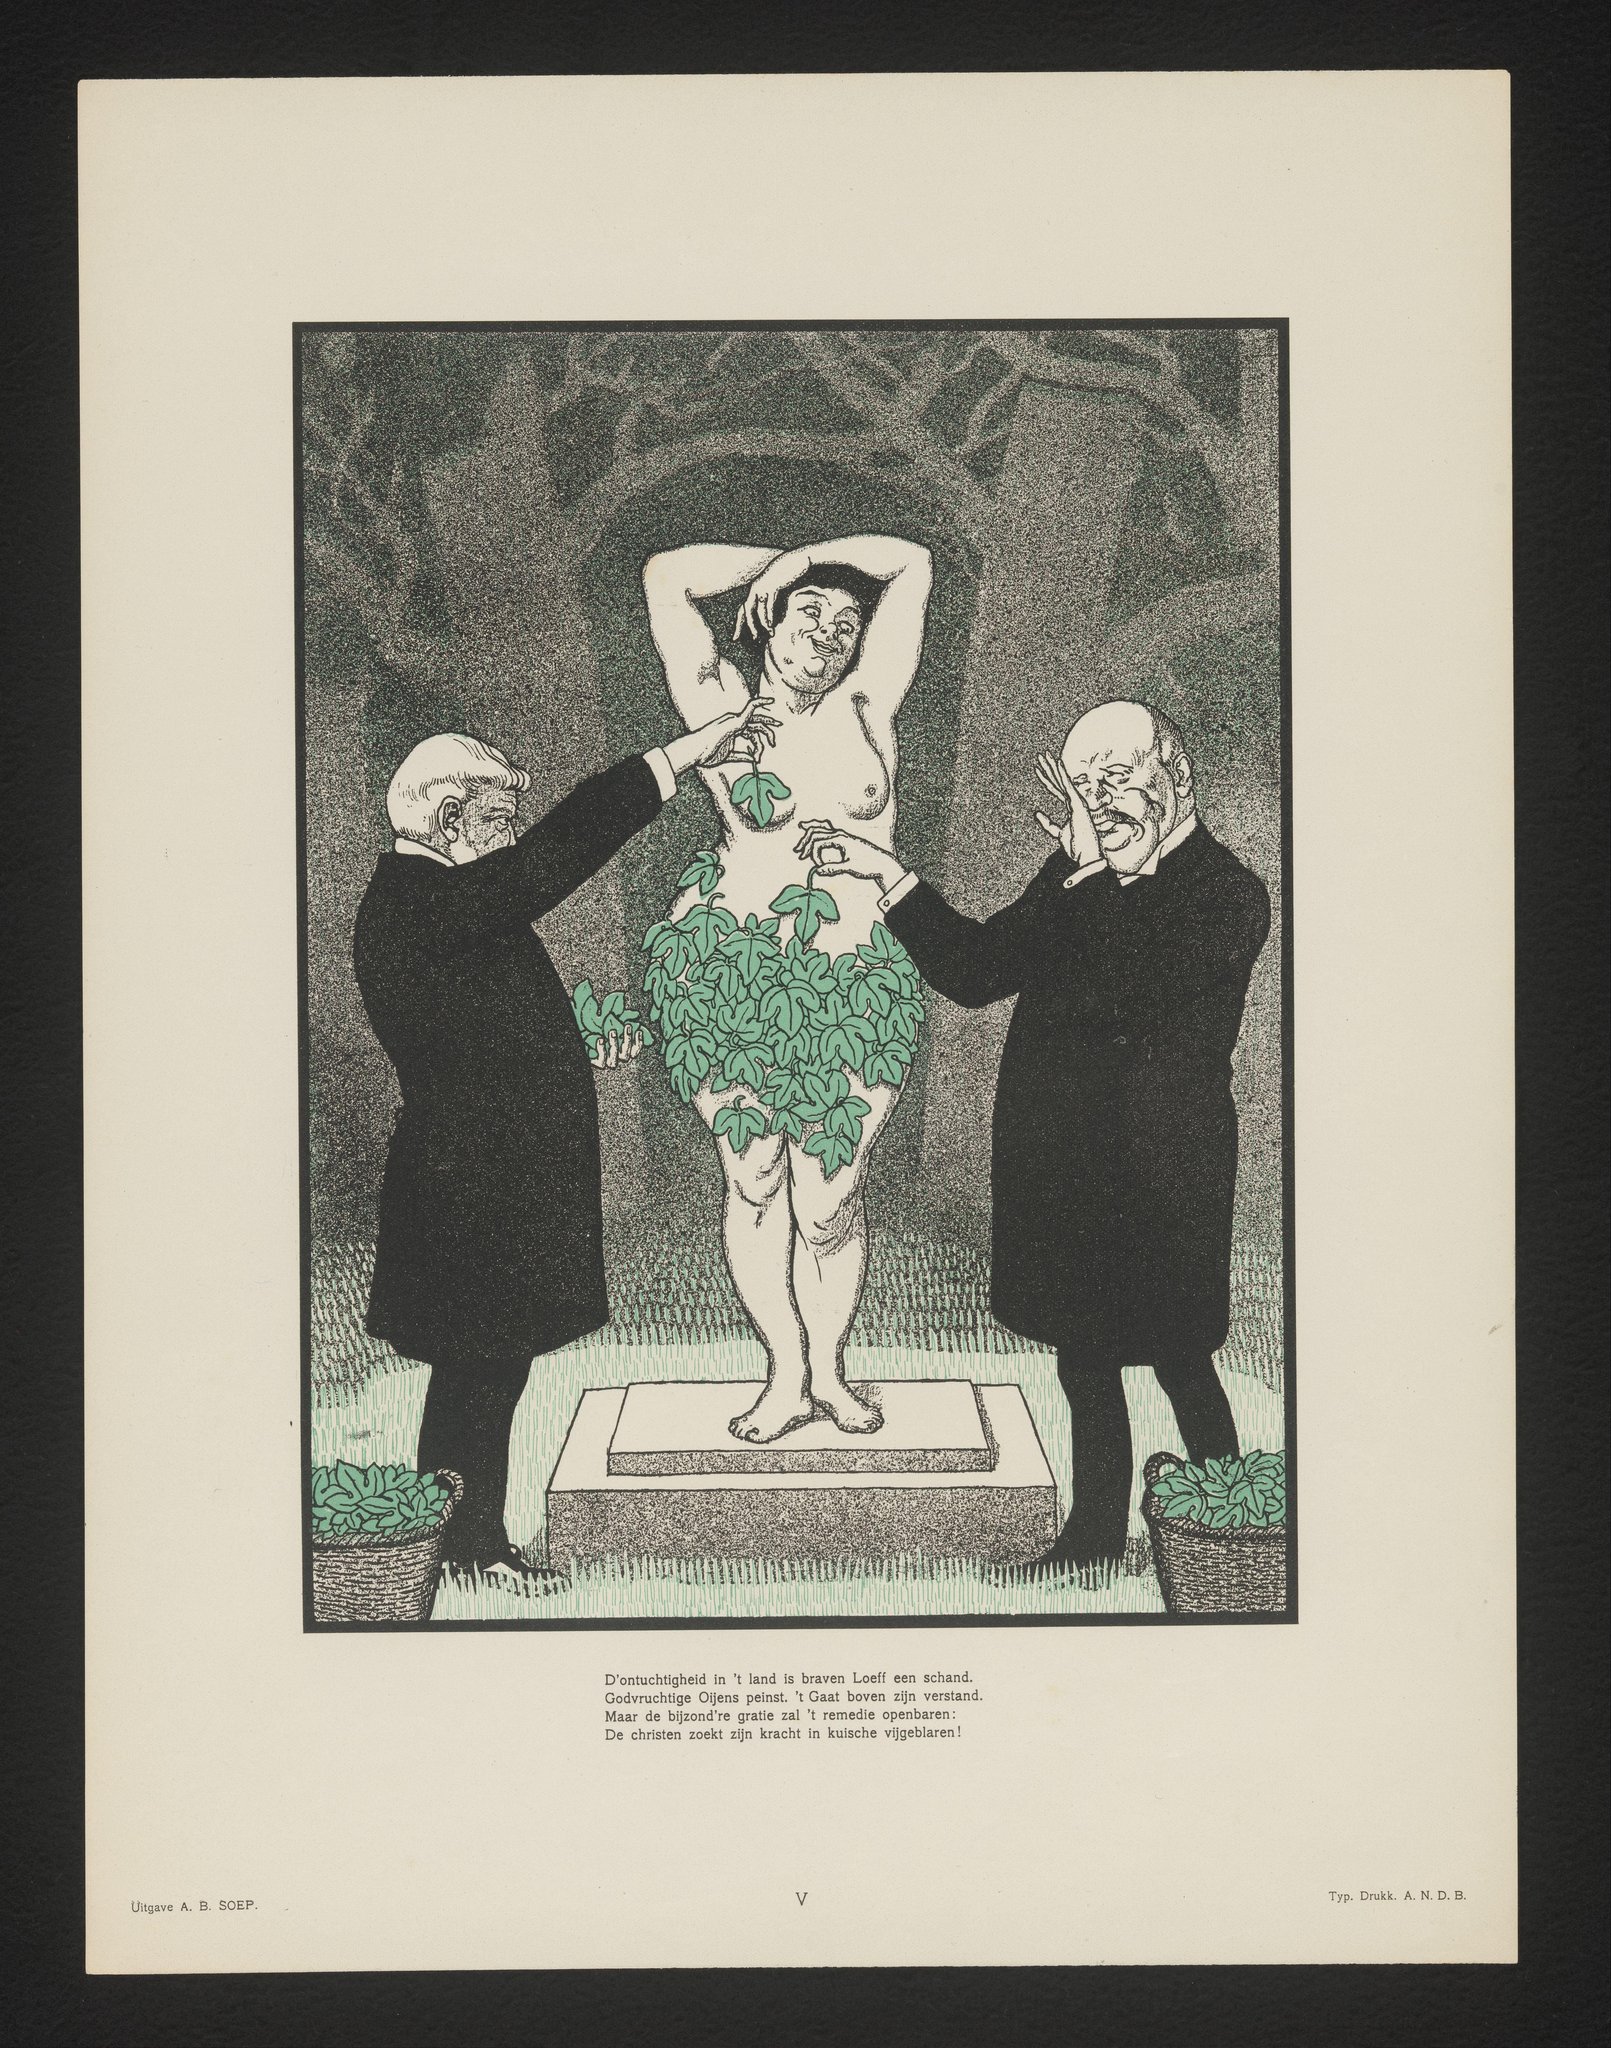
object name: print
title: Onder zwart régime : 12 karikatuur-teekeningen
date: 1905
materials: paper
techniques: autotype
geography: amsterdam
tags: the hague, abraham kuyper, piece of sculpture, reproduction of a piece of sculpture, monument, statue, political caricatures and satires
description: De ministers Loeff en De Marez Oyens bedekken een standbeeld van de naakte Abraham Kuyper met vijgenbladeren. Met vierregelig onderschrift. Onderdeel van de prentserie 'Onder Zwart Regime'.